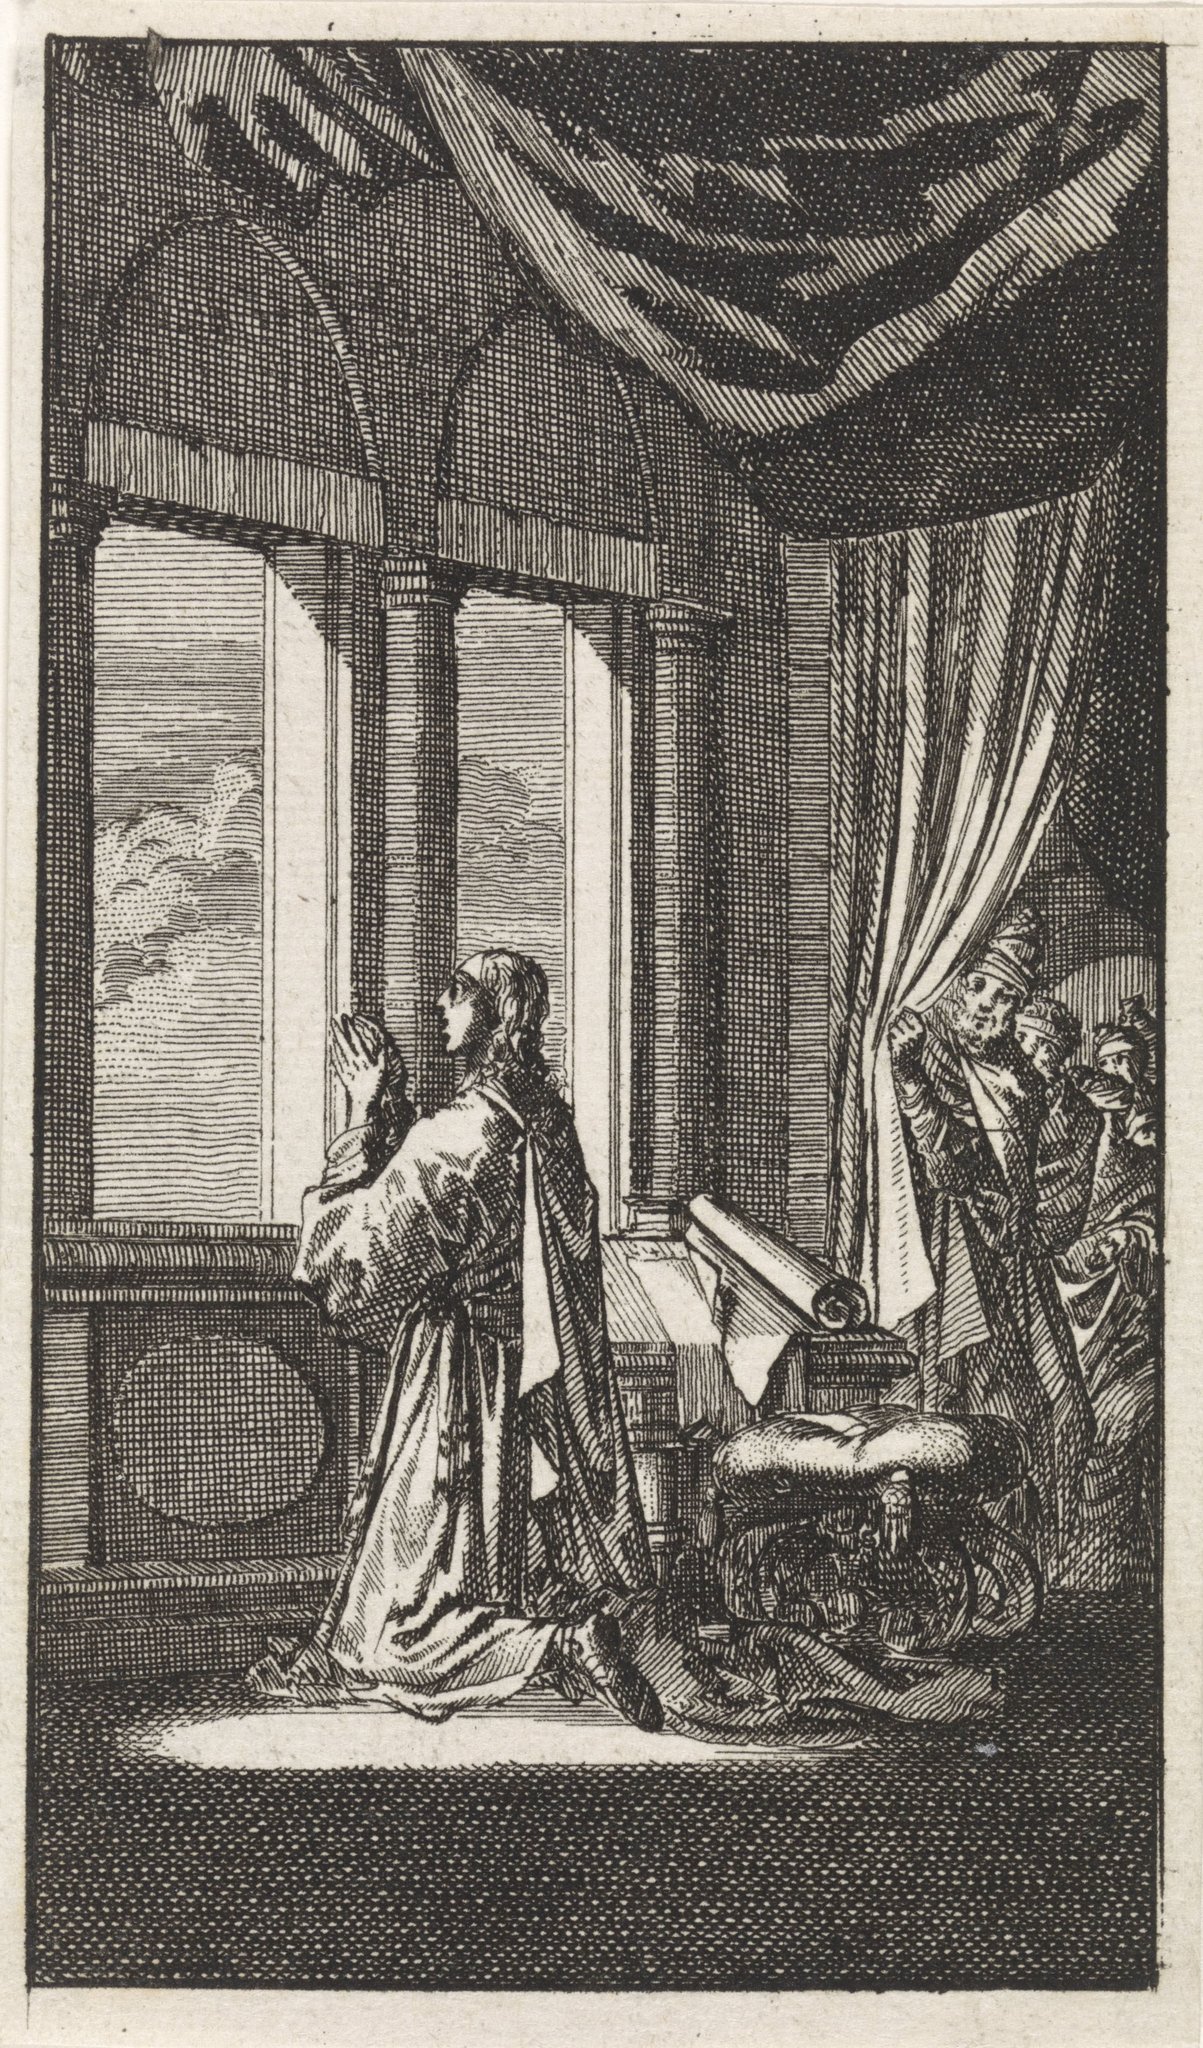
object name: print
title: Daniël geknield voor een venster wordt bespied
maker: jan luyken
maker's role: draughtsman, print maker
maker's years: 1649-1712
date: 1712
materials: paper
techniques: etching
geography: amsterdam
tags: daniel, while praying on his knees before an open window, is discovered by the conspirators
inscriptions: collector's mark: Lugt 2228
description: Proefdruk van illustratie voor: Luyken, Jan. Bybel printen. Amsterdam: Pieter Arentsz. II (wed.) en Cornelis van der Sys, 1712, p. 16.